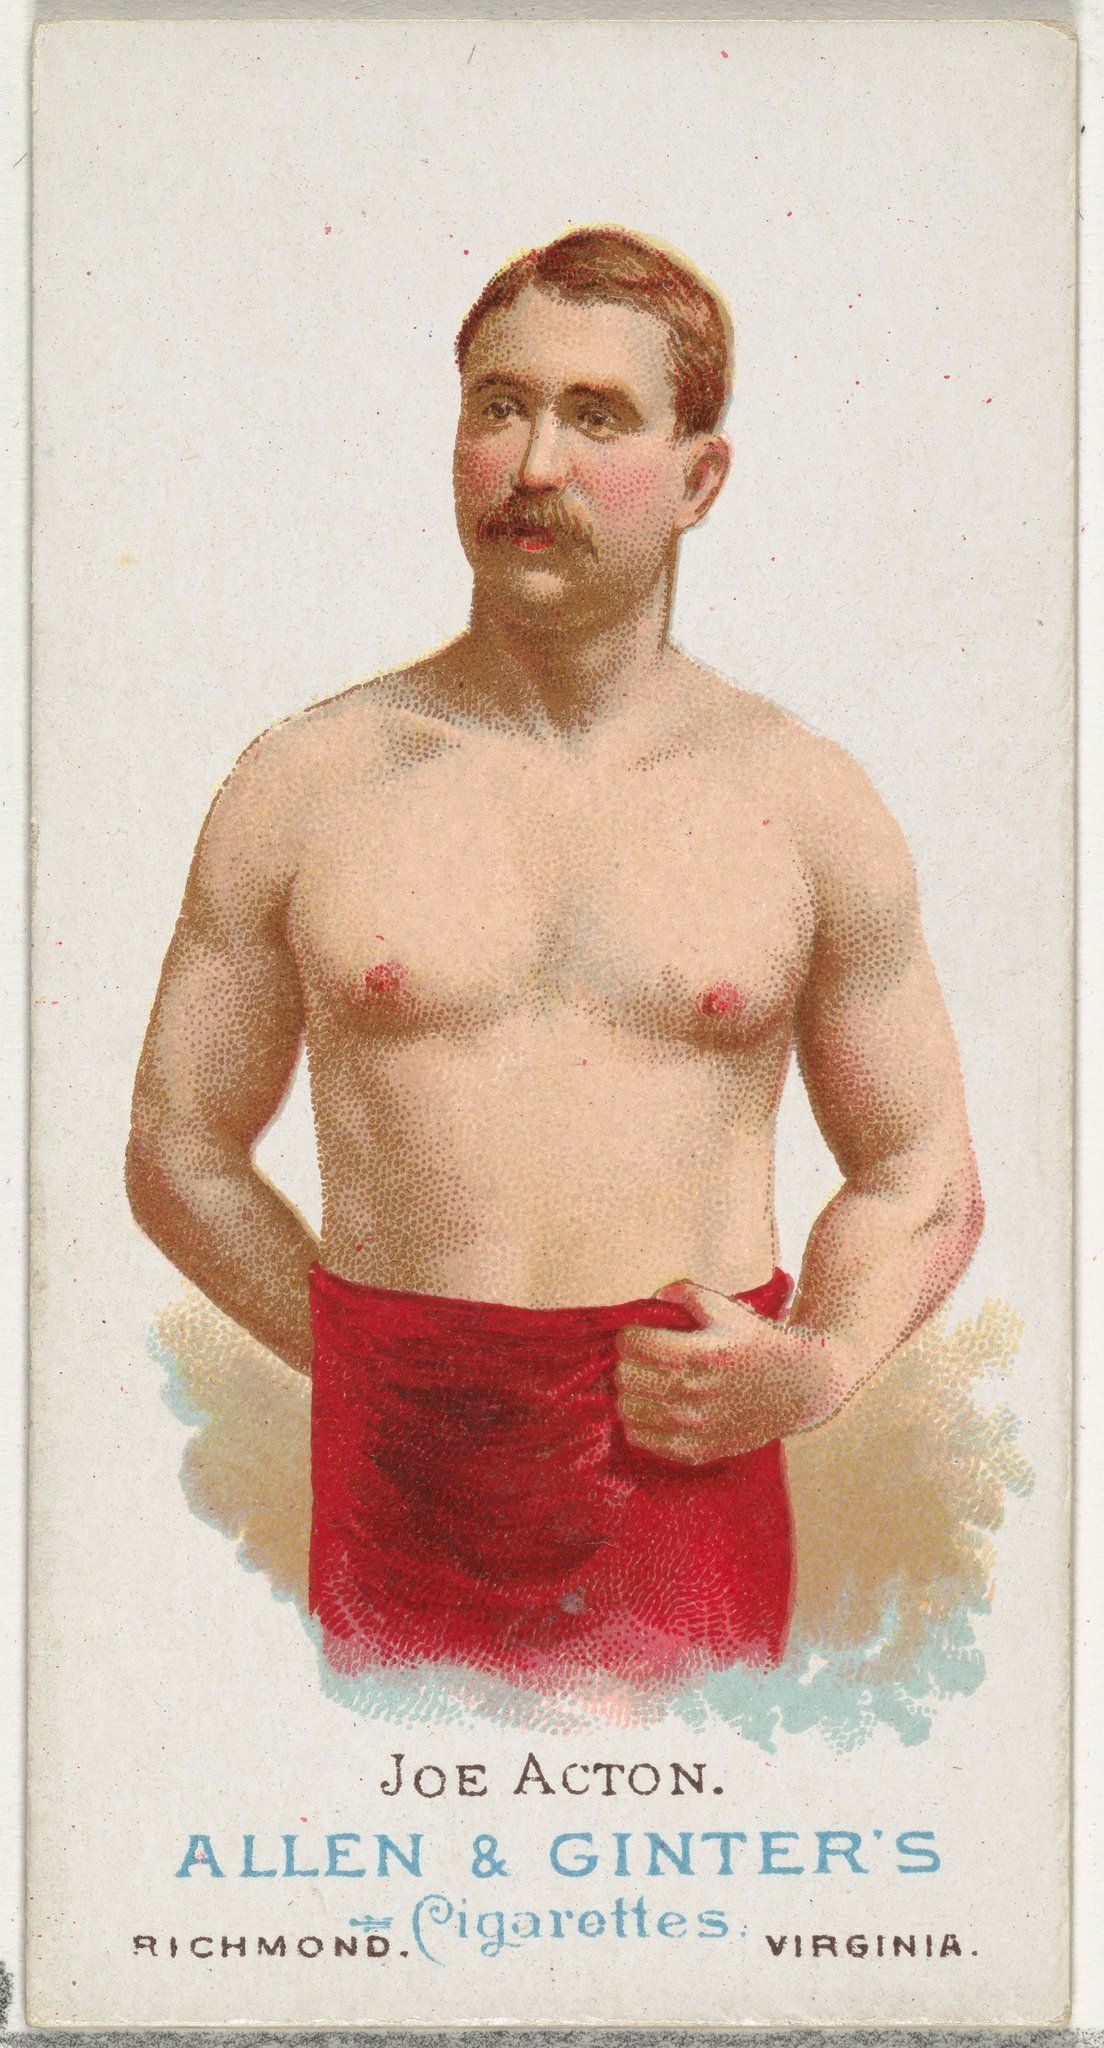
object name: print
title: Joe Acton, Wrestler, from World's Champions, Series 1 (N28) for Allen & Ginter Cigarettes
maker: allen & ginter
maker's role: publisher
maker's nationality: american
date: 1887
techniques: color lithograph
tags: men,portraits,athletes